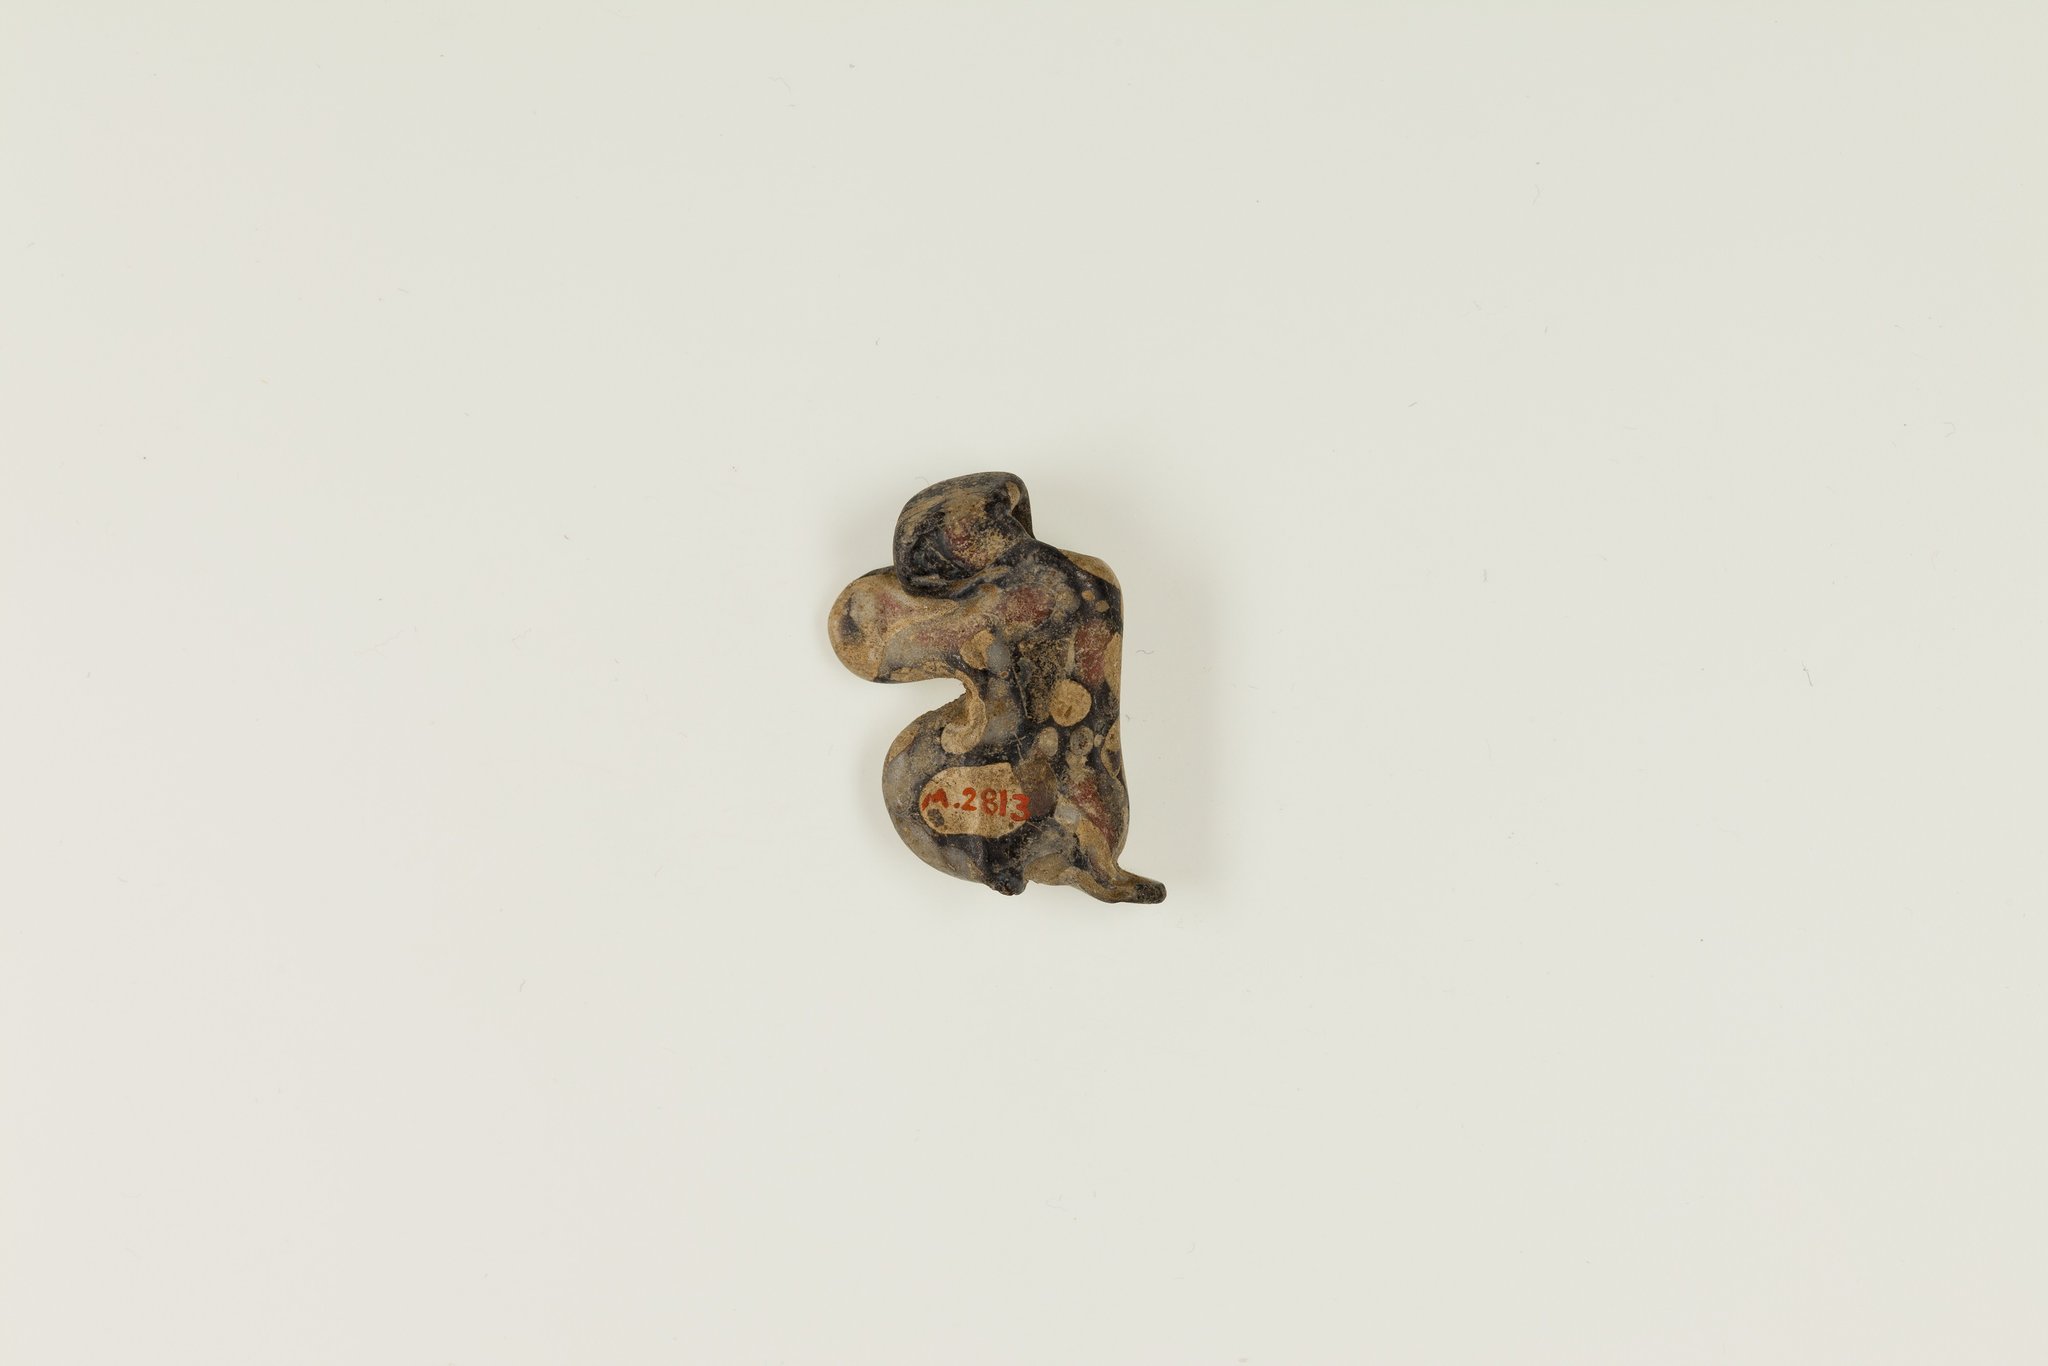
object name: amulet, taweret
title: Taweret amulet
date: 100 BCE-100 CE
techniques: mosaic glass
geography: egypt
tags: taweret